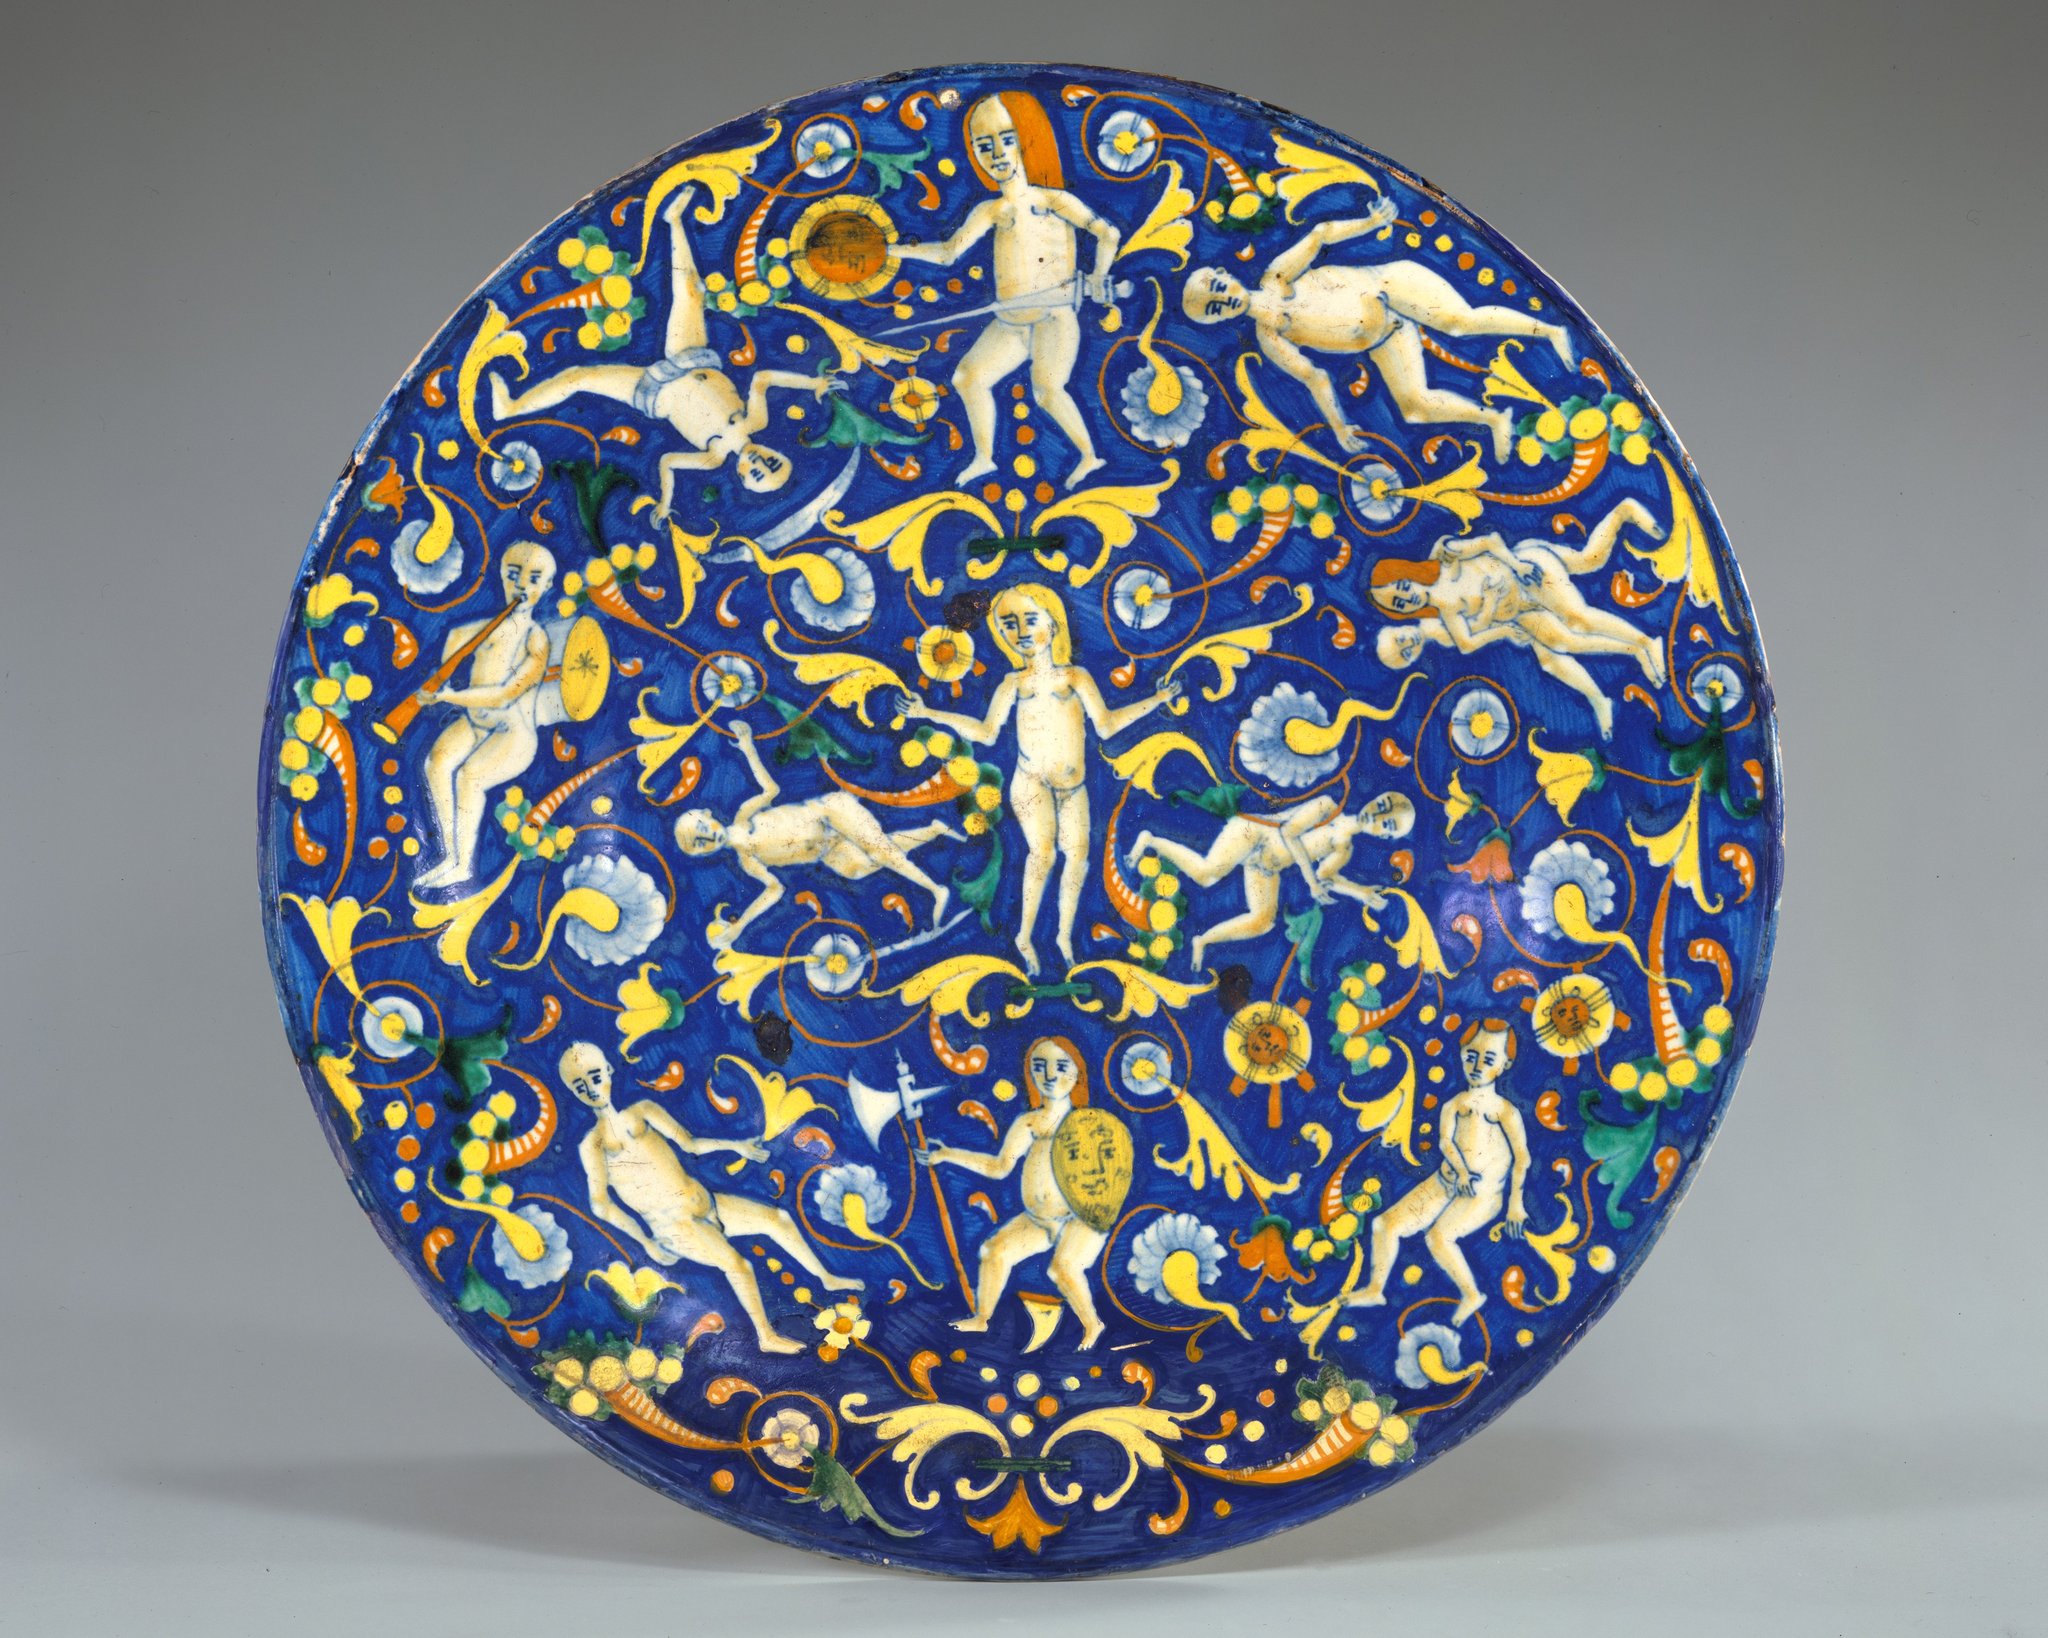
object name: dish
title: Dish (piatto)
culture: italian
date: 1530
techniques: maiolica, glazing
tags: male nudes,female nudes